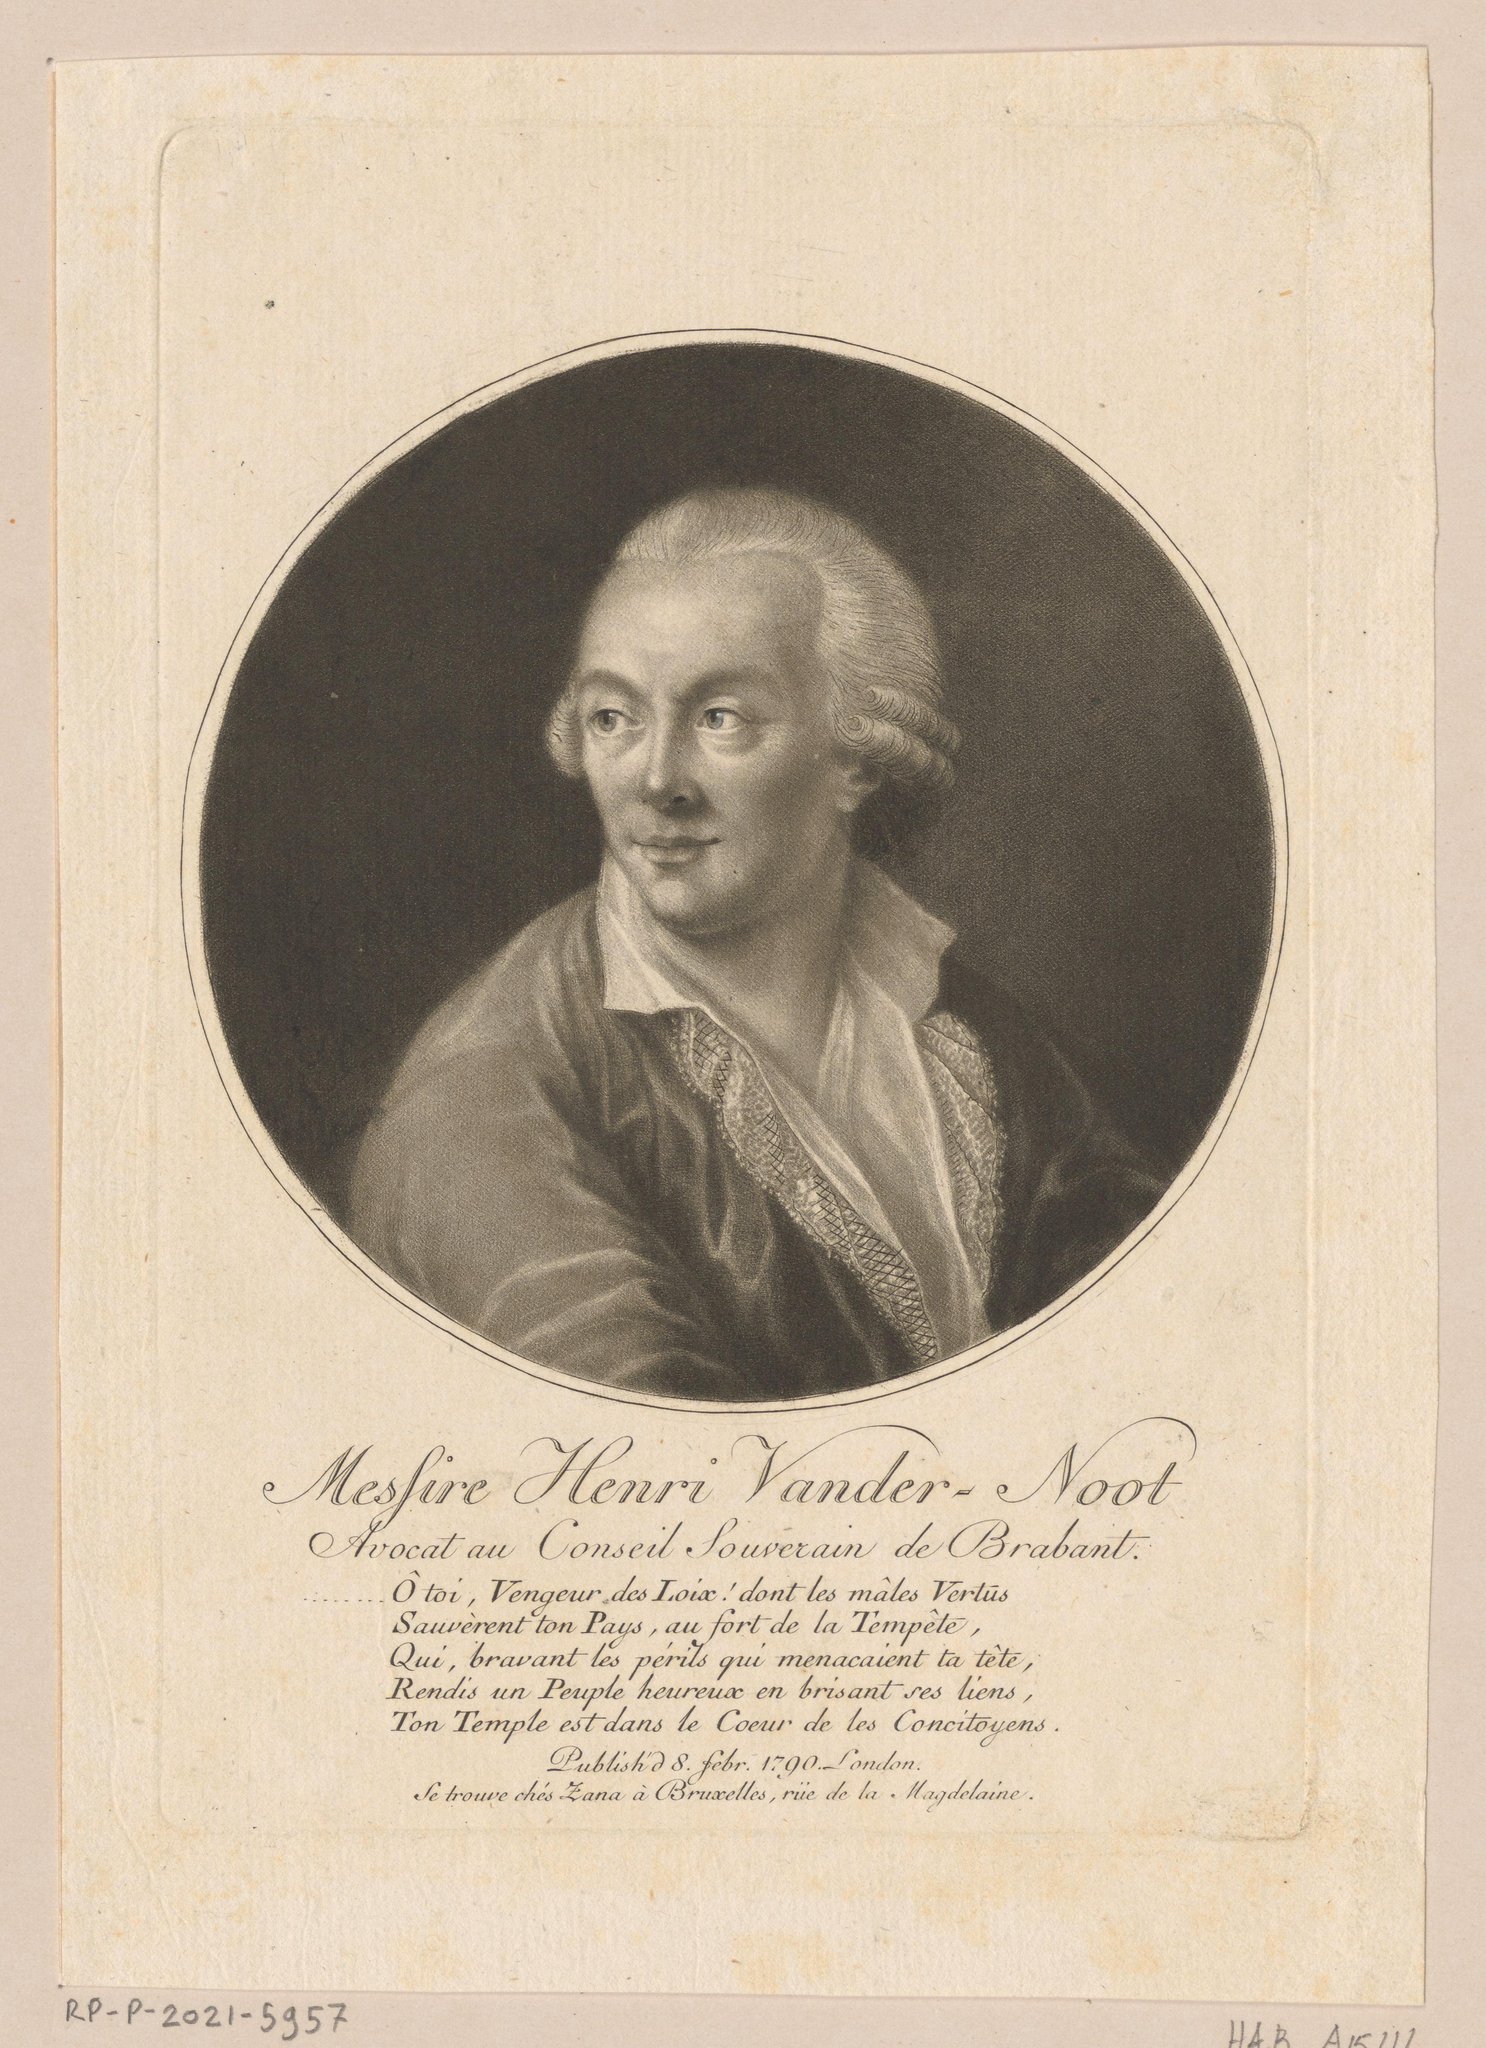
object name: print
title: Portret van Hendrik Karel Nicolaas van der Noot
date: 1790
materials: paper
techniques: engraving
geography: london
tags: brussels, historical persons, politician, e.g. party leader